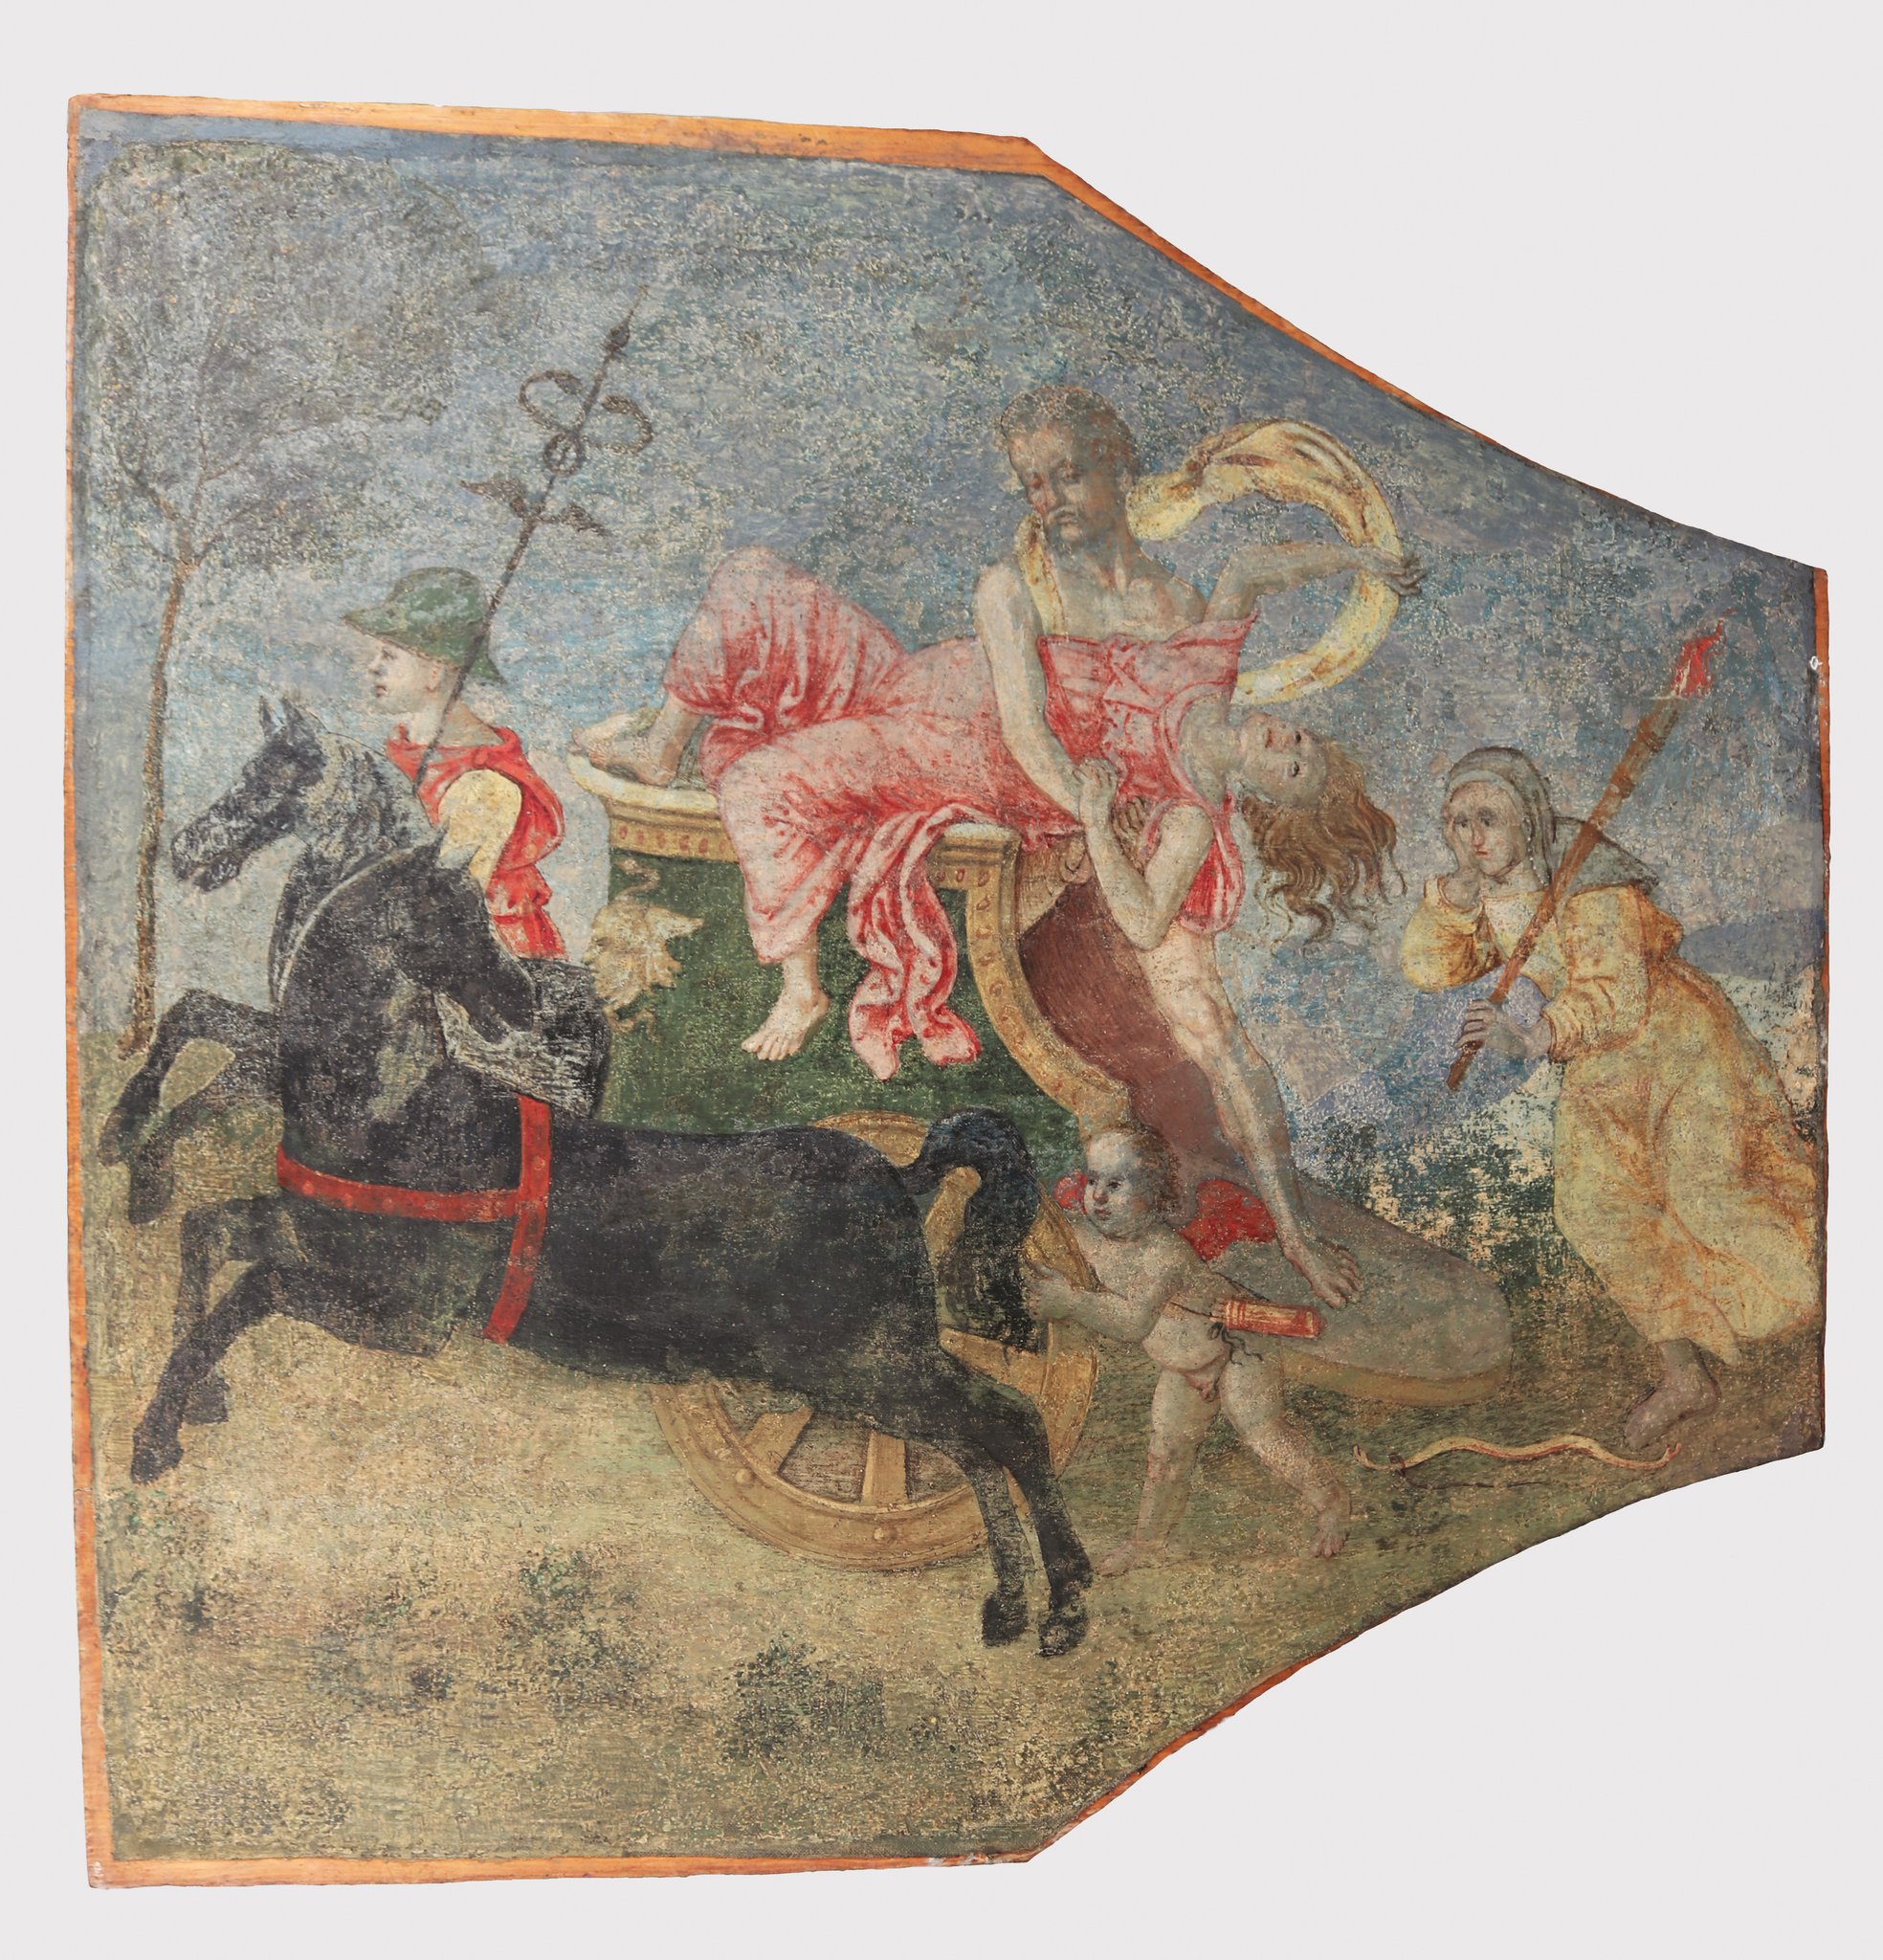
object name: ceiling panel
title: Rape of Proserpine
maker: pinturicchio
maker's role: artist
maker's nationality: italian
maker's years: 1454-1513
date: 1509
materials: canvas, panel, wood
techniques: fresco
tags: mythology,suffering,men,women,putti,horses,chariots